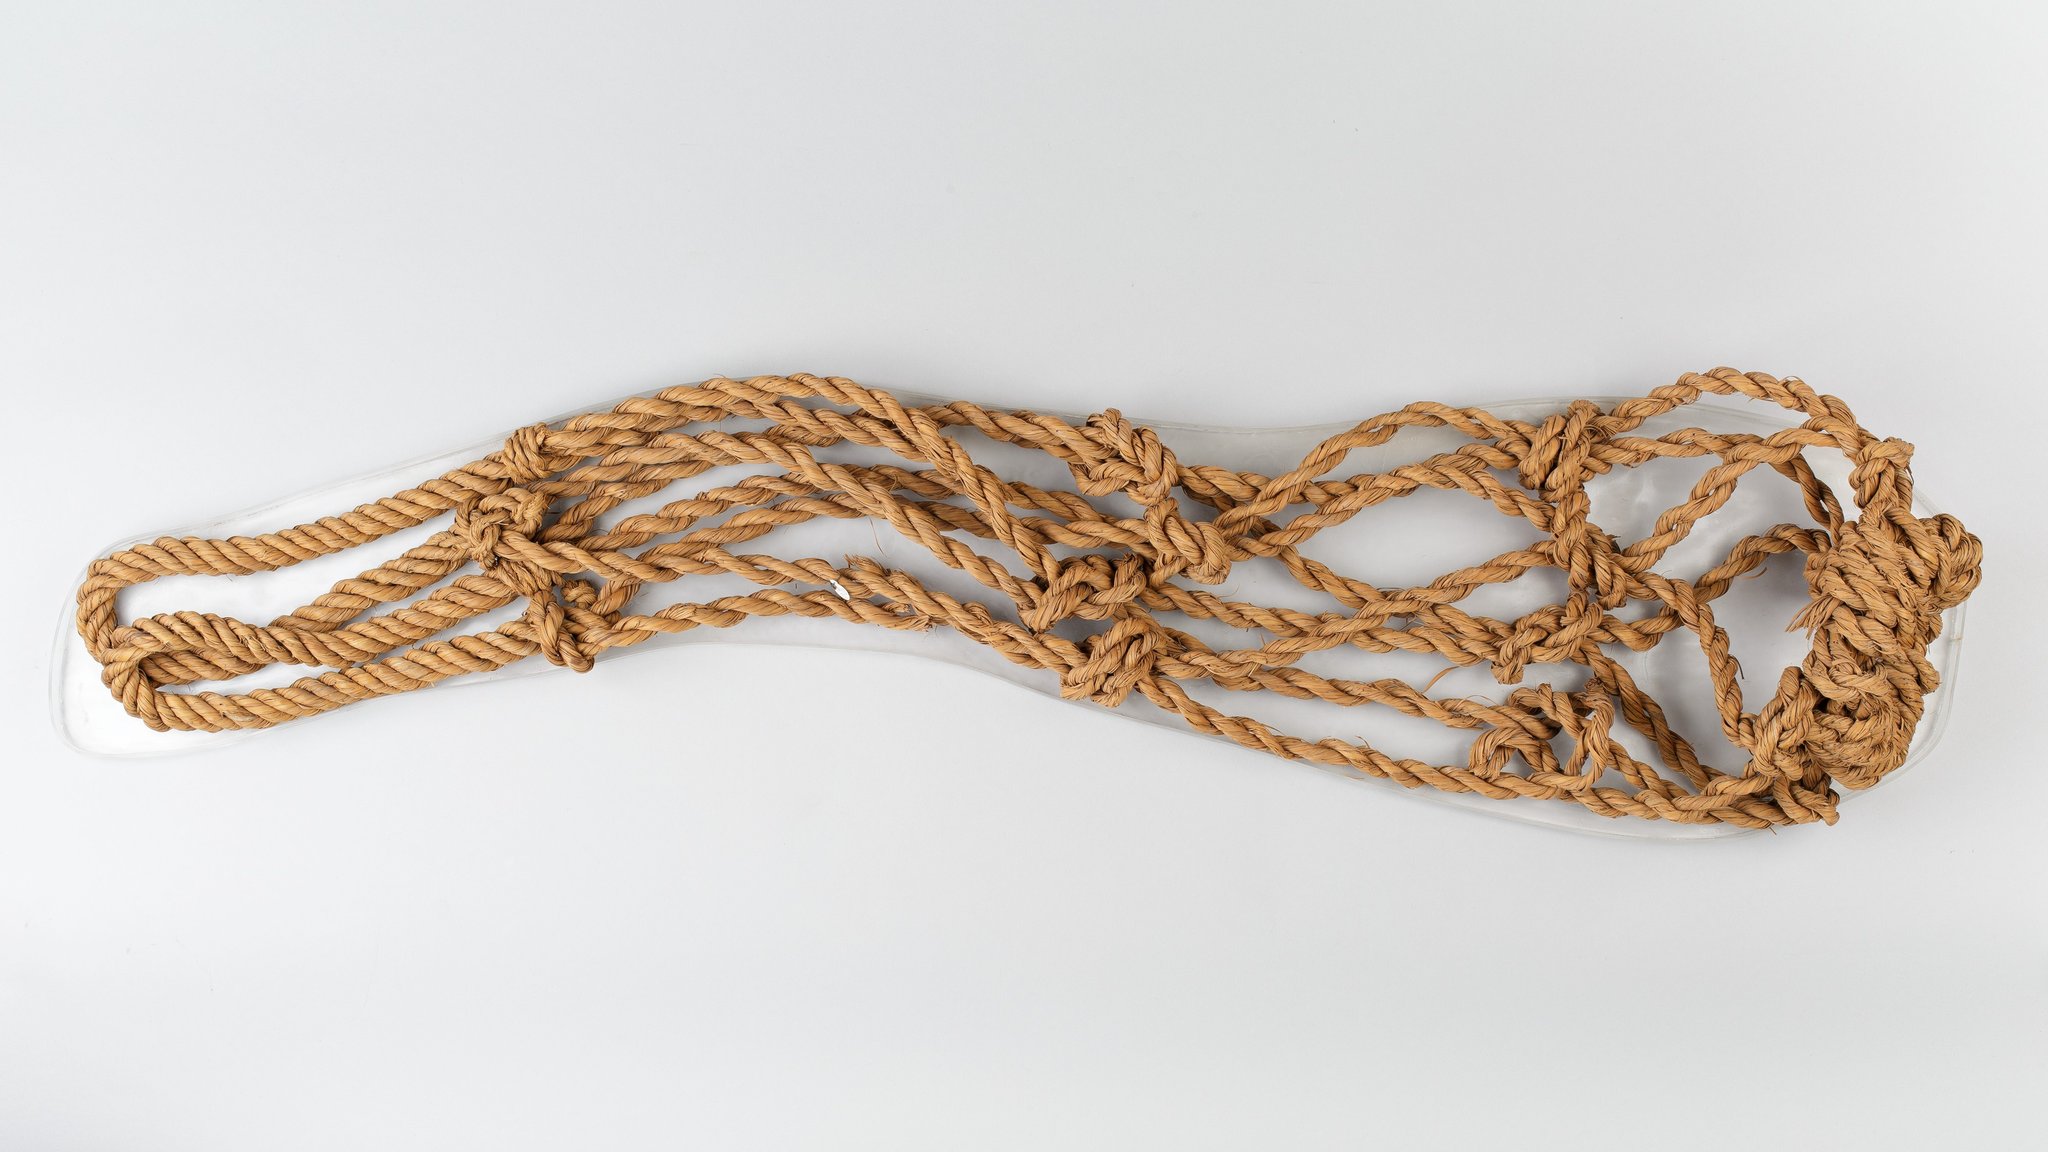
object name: rope jar sling, ipy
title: Rope Jar Sling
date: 2030-1640 BCE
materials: fiber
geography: egypt